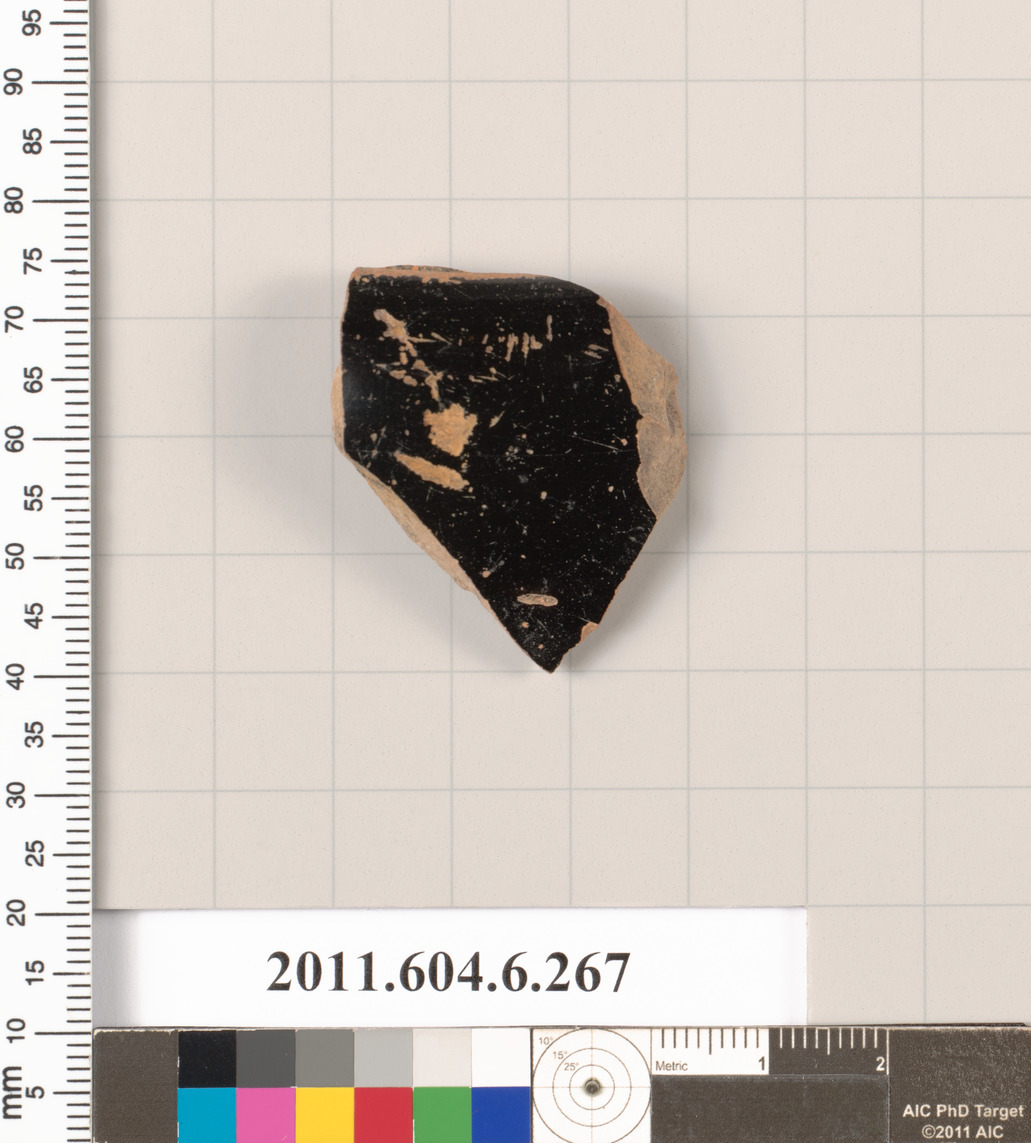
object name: undetermined open shape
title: Terracotta fragment of an open shape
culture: greek, attic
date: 500-401 BCE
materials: terracotta